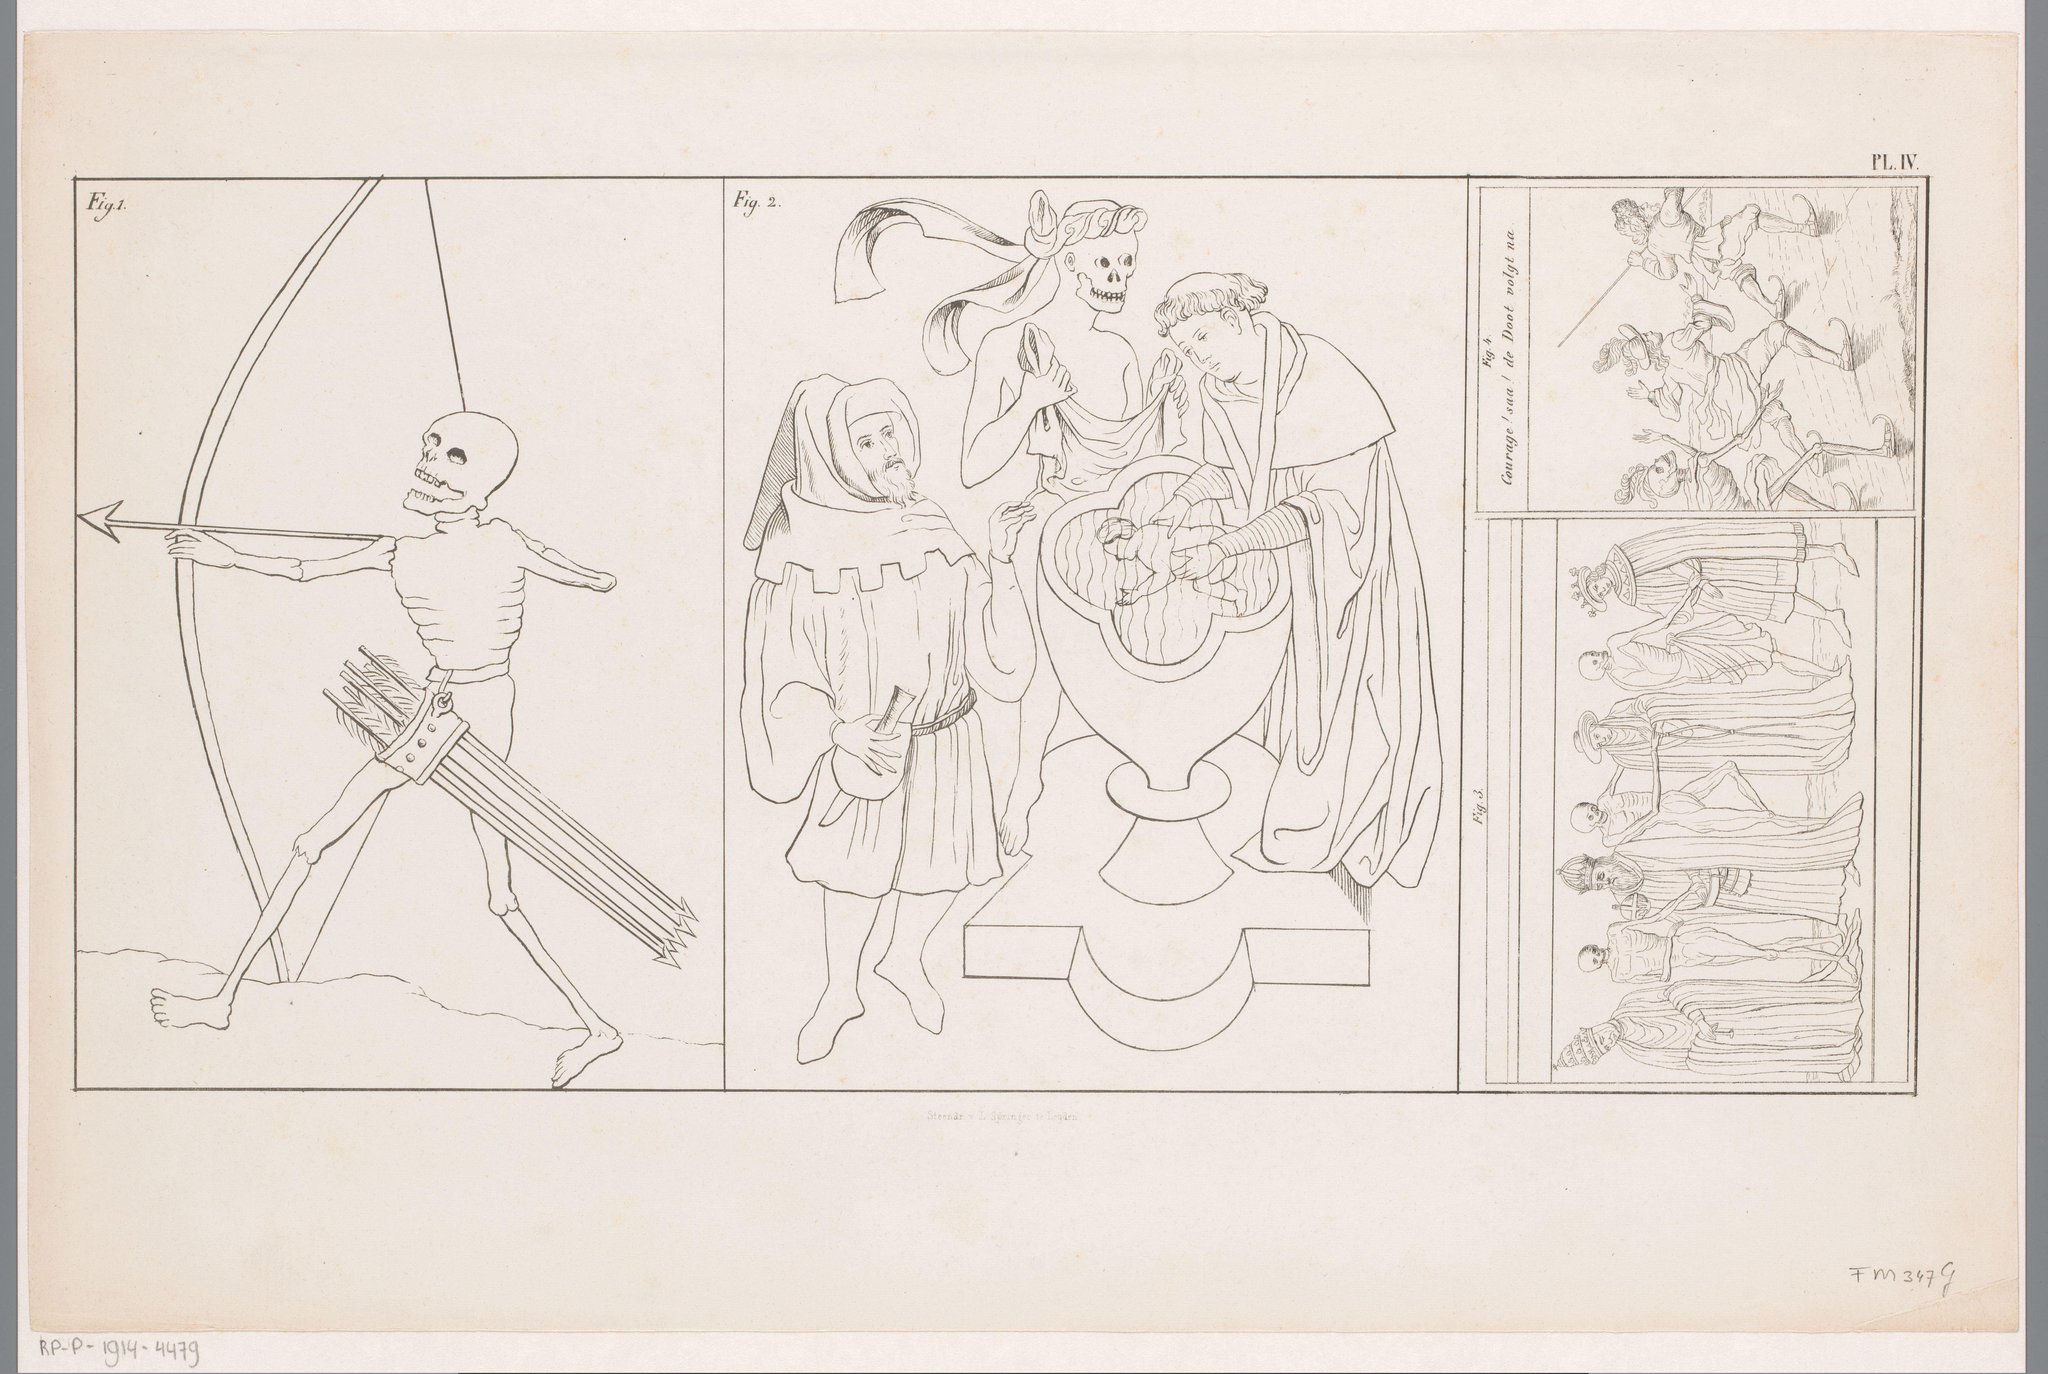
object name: print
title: Dodendans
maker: leendert springer (i)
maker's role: draughtsman, painter, print maker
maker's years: 1789-1871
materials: paper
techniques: lithograph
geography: leiden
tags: dance of death; death together with one or more human beings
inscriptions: collector's mark: Lugt 2228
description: Prent uit: Kist, N.C, 'Het humoristisch karakter der christelijke kunst in het tijdvak, hetwelk de kerkhervorming der XVIde eeuw heeft voorbereid; zigtbaar vooral in de kerkelijke architectuur en de doodendansen', Nederlandsch archief voor kerkelijke geschiedenis 4 (1844).